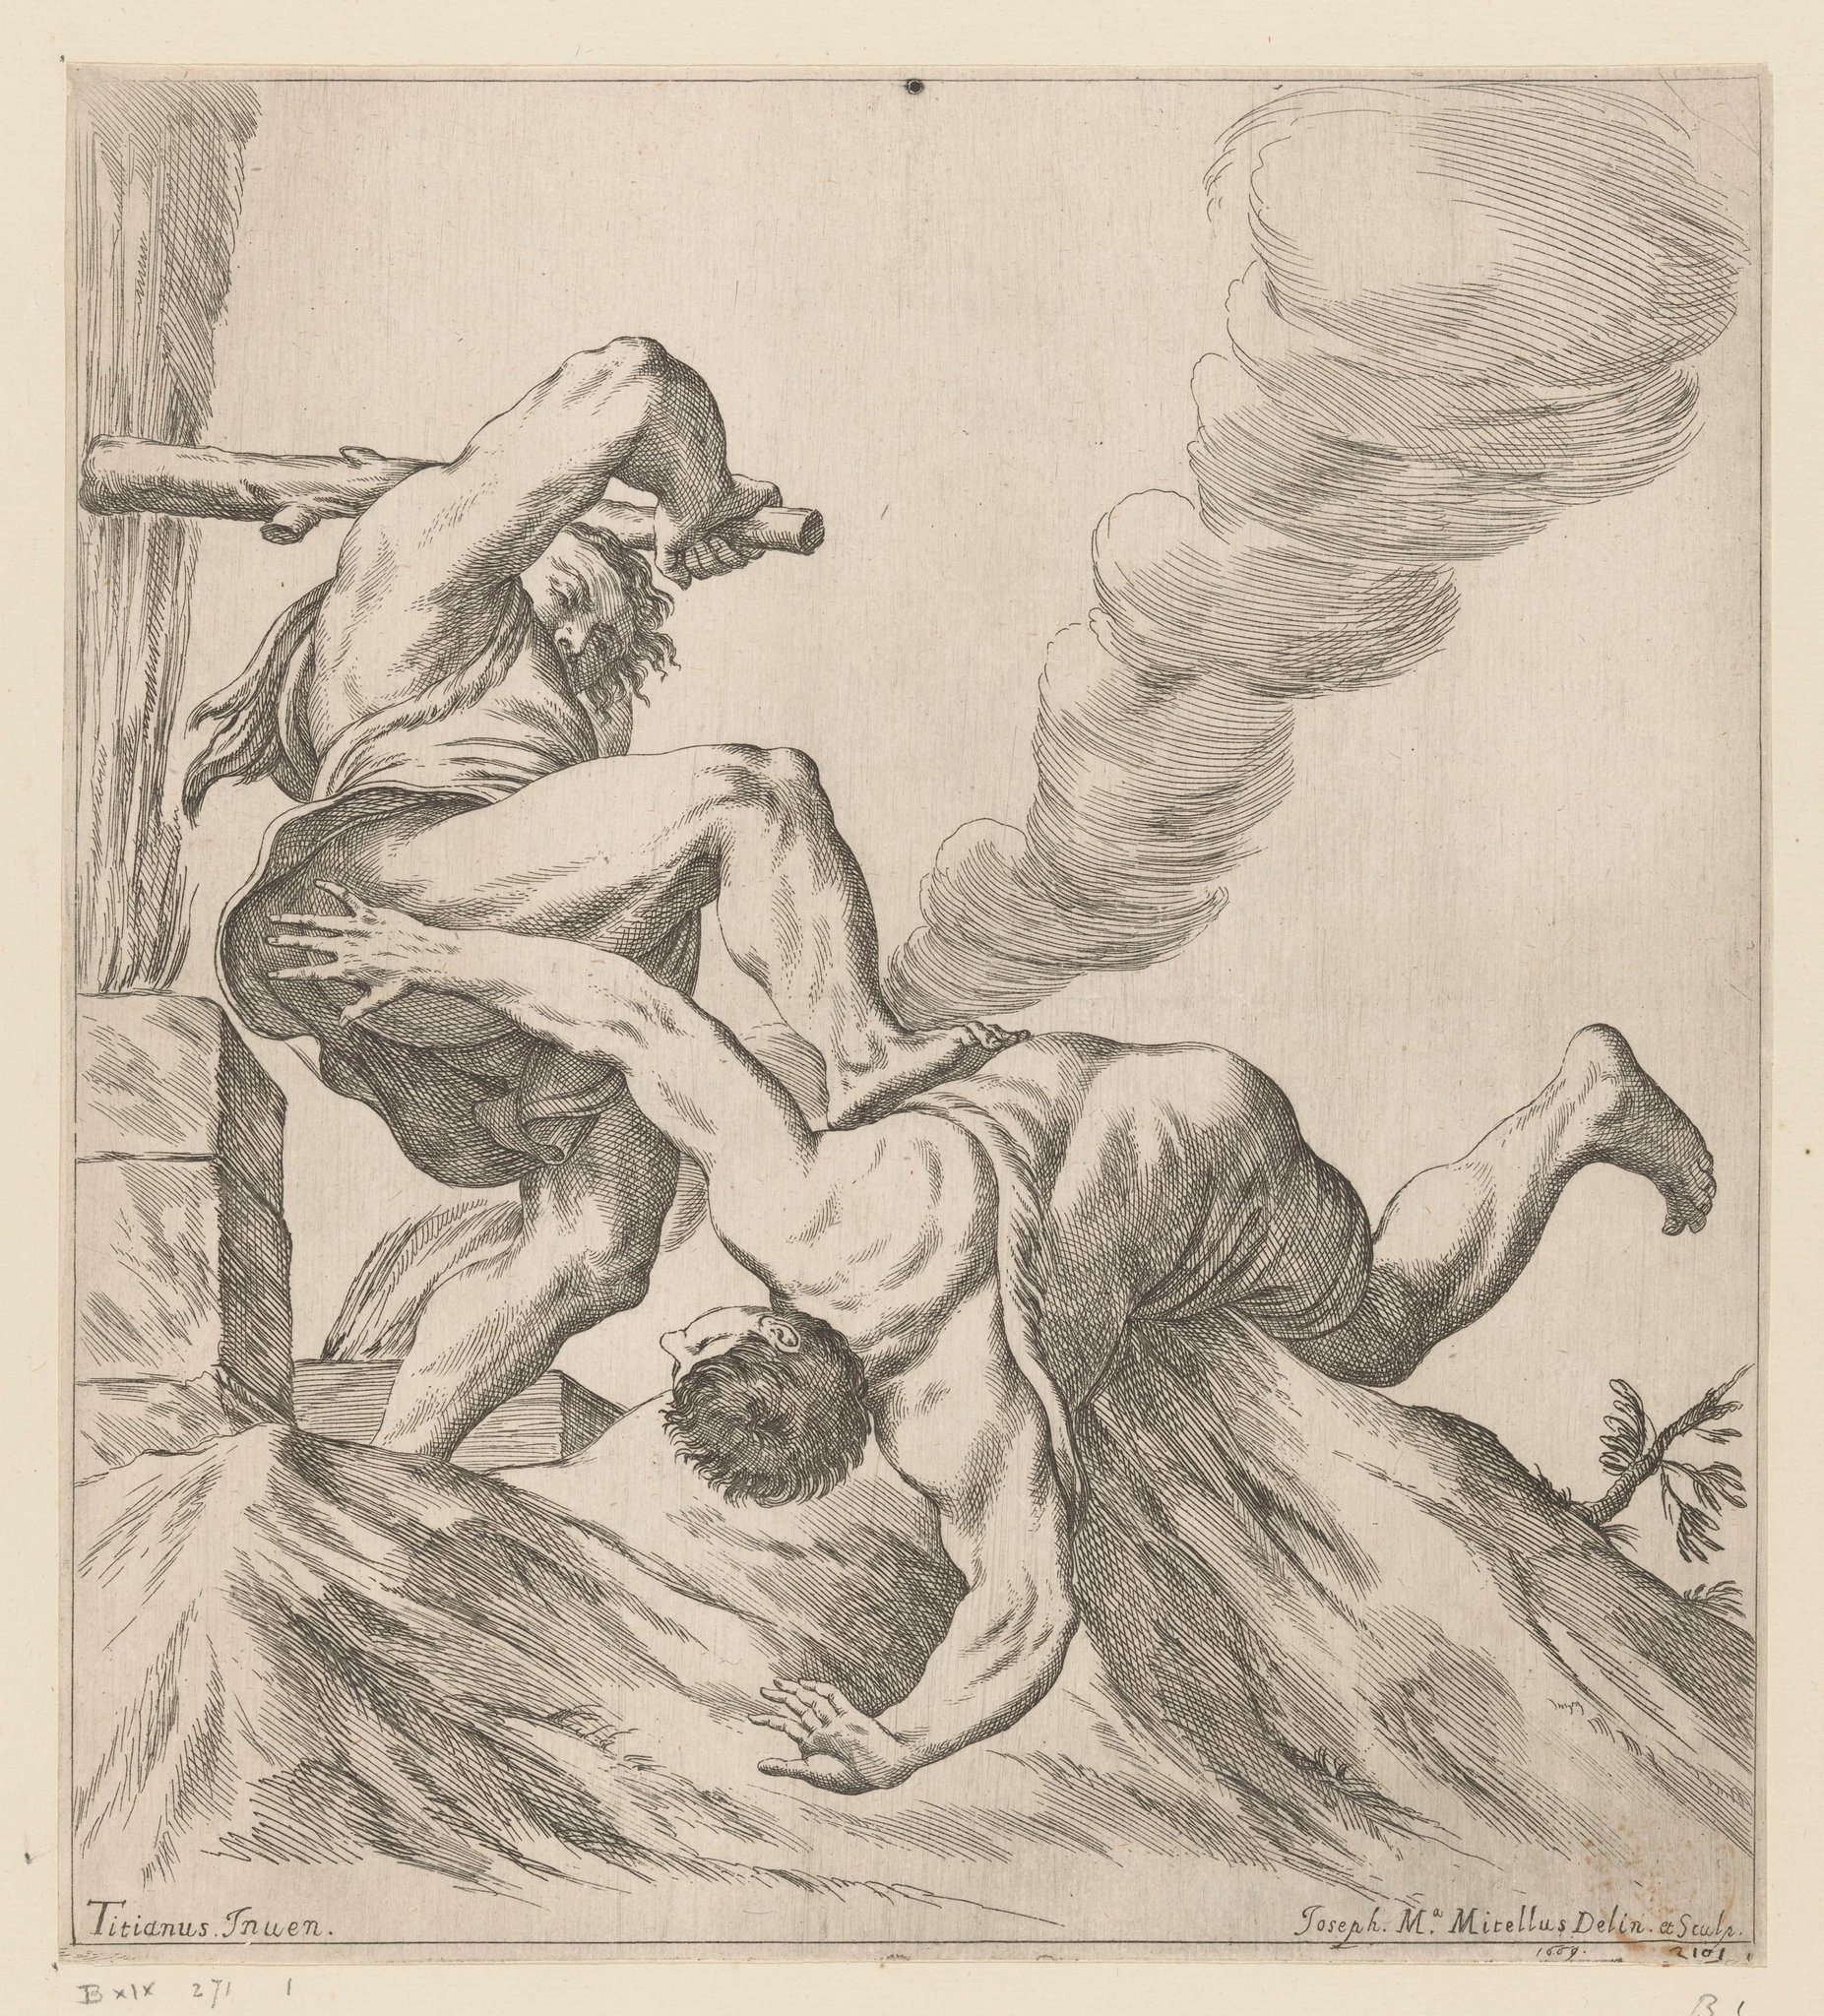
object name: print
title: Kaïn slaat Abel dood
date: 1669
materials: paper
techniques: etching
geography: italy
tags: the killing of abel: cain slays him with a stone, a club or a jaw-bone, alternatively with a spade or another tool as weapon, weapons for striking a blow, fighting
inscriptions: collector's mark: Lugt 240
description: Kaïn staat op het punt om Abel dood te slaan met een knots. Op de achtergrond een rookpluim.